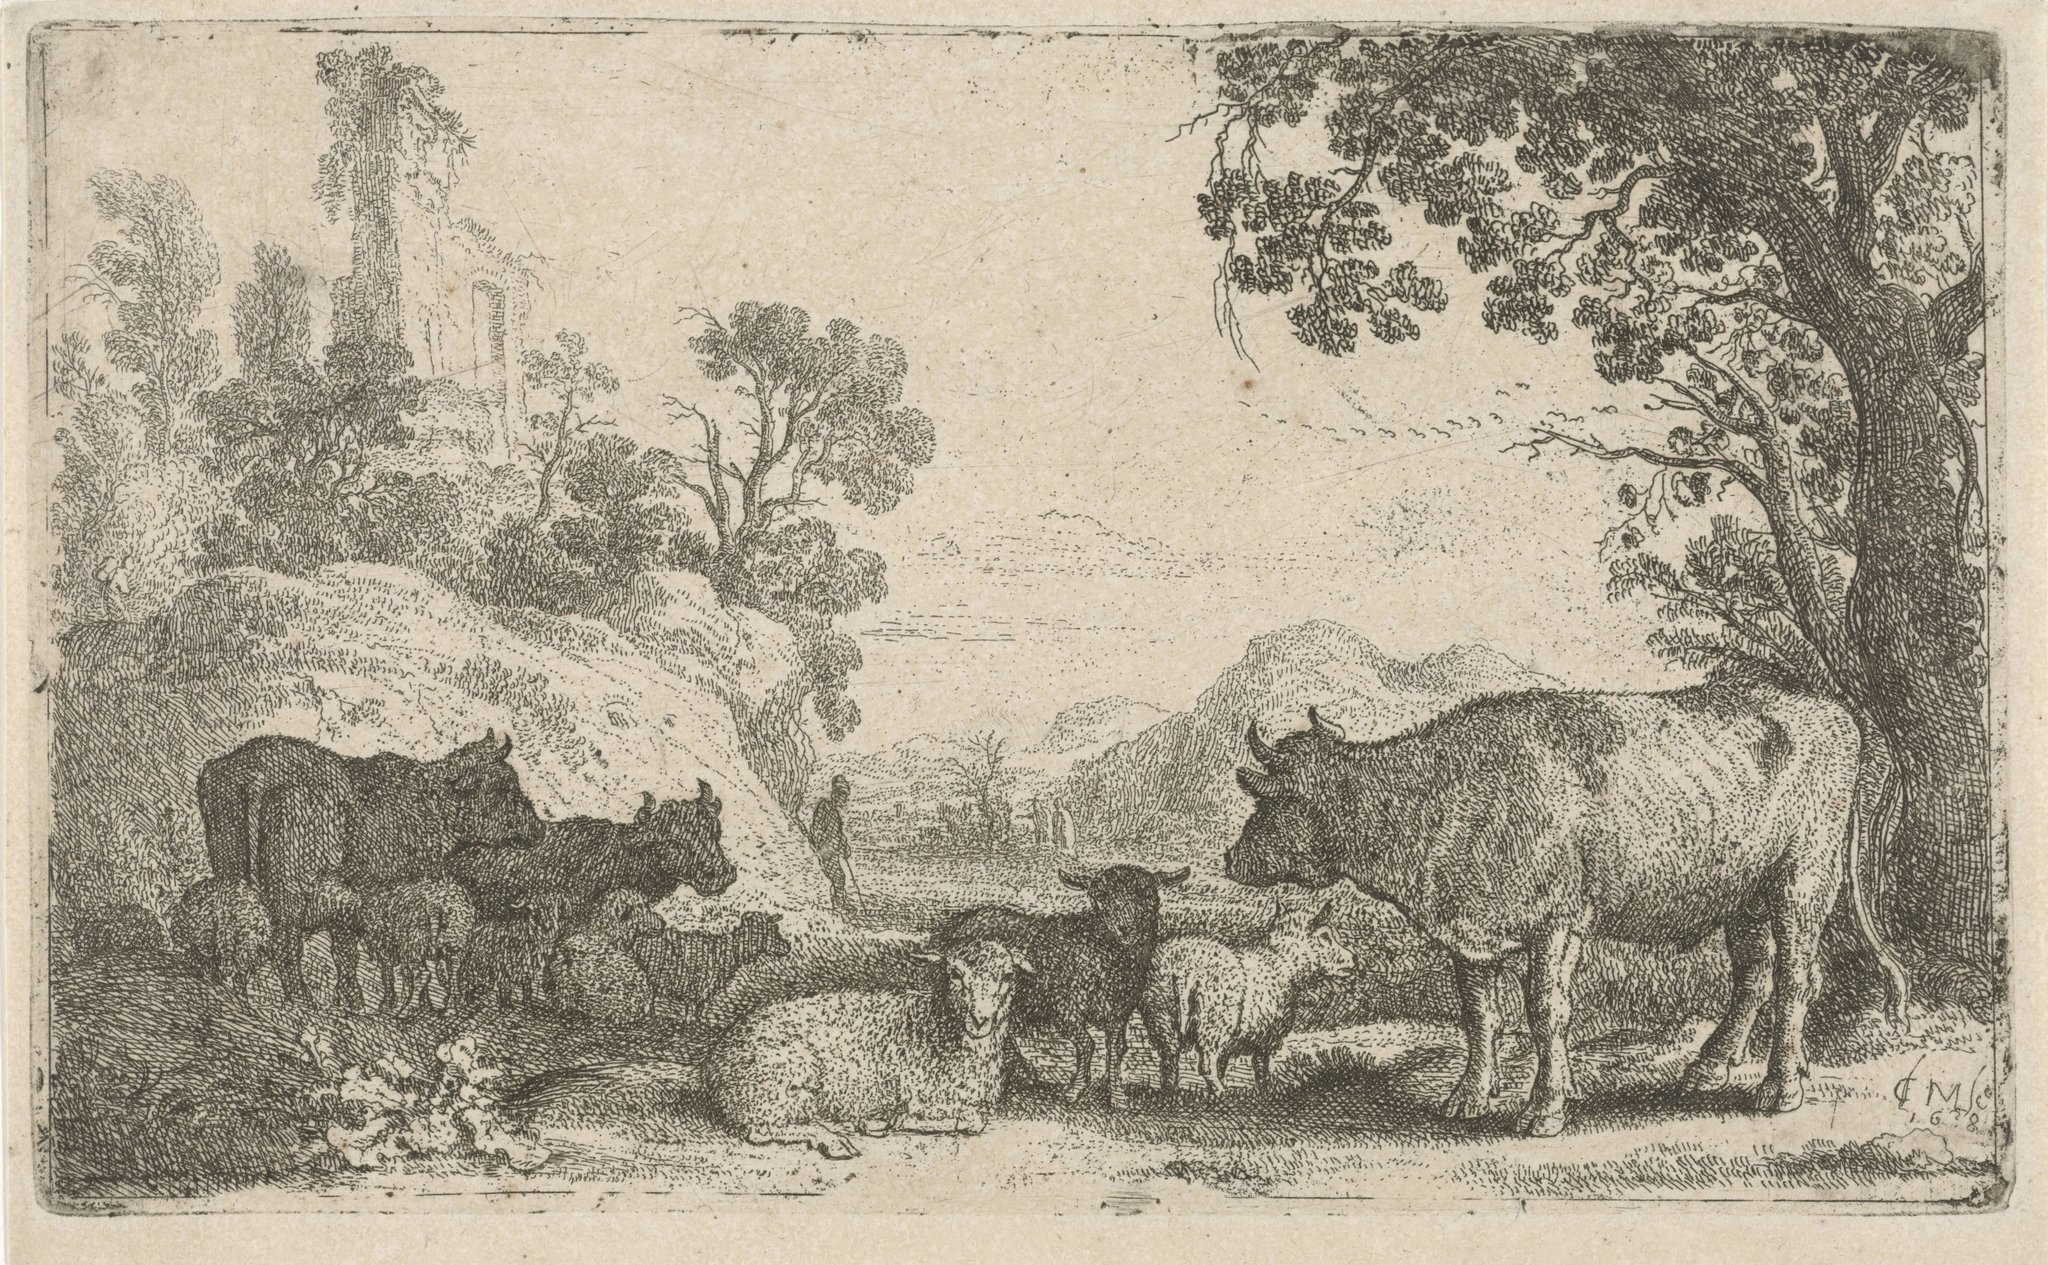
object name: print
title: Landschap met vee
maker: claes moeyaert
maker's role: draughtsman, painter, print maker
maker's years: 1592-1655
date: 1638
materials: paper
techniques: etching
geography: amsterdam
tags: cattle, landscape with ruins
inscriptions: collector's mark: Lugt 240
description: Landschap met koeien en schapen op de voorgrond. Op de heuvel links een begroeide ruïne. Onderaan de berg een herder.